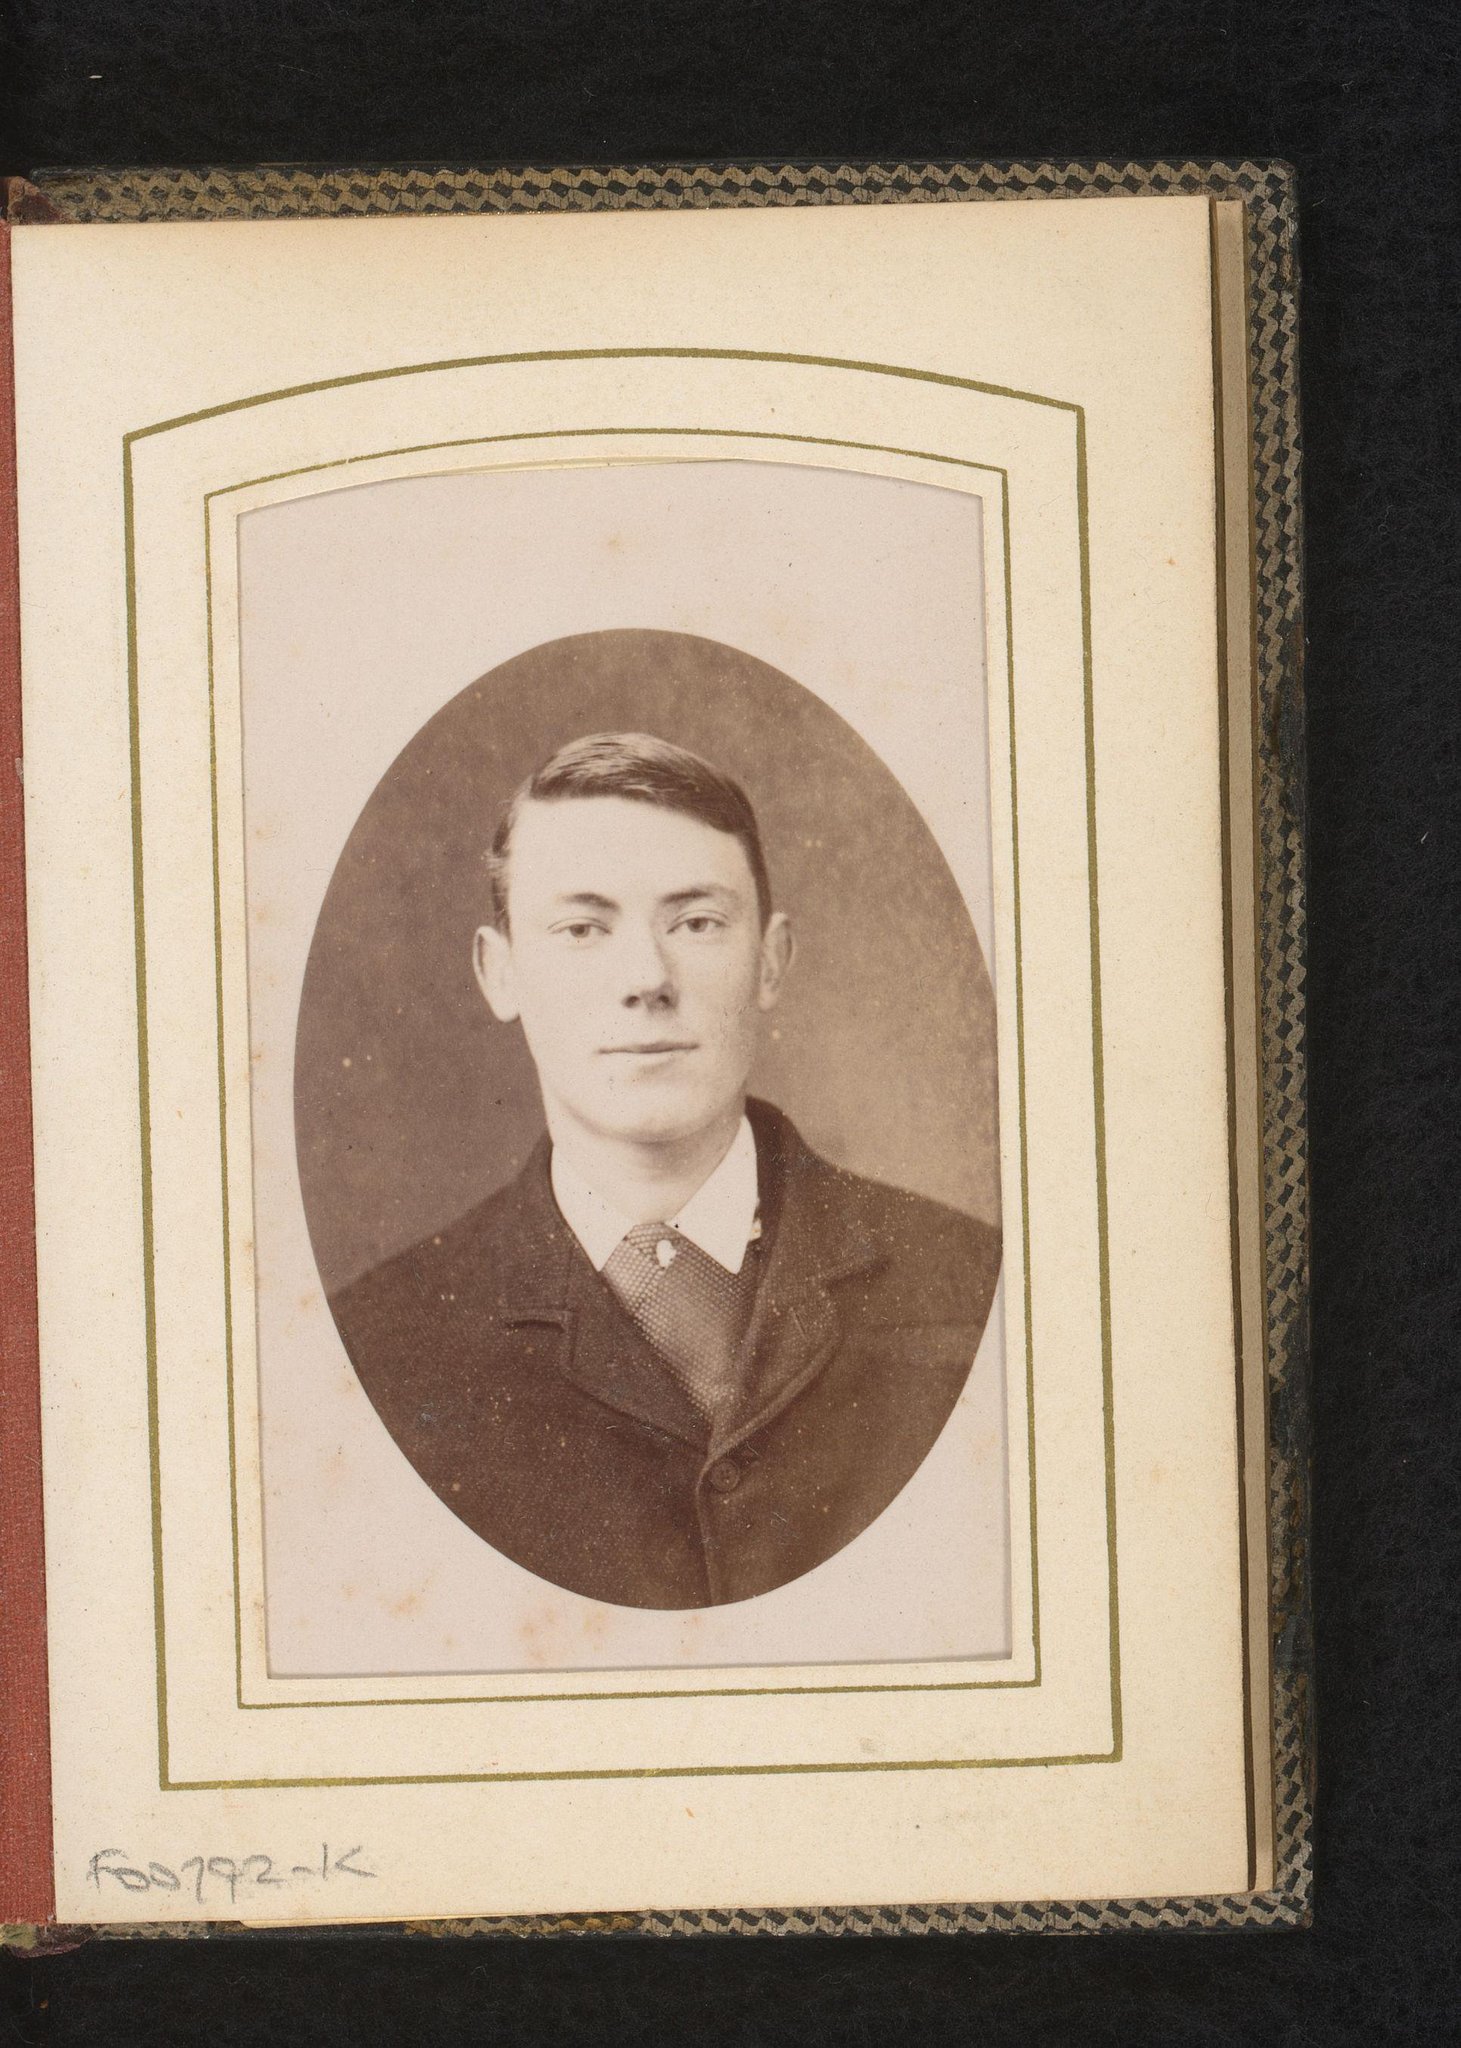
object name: carte de visite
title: Portret van een man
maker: pieter johannes duyshart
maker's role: fotograaf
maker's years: -1889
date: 1870-1900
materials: cardboard, photographic support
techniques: albumen print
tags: adult man, historical persons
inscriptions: inscription: ‘P.J. Duyshart, Photographer/ Duke Street/ Chelmsford (...)’